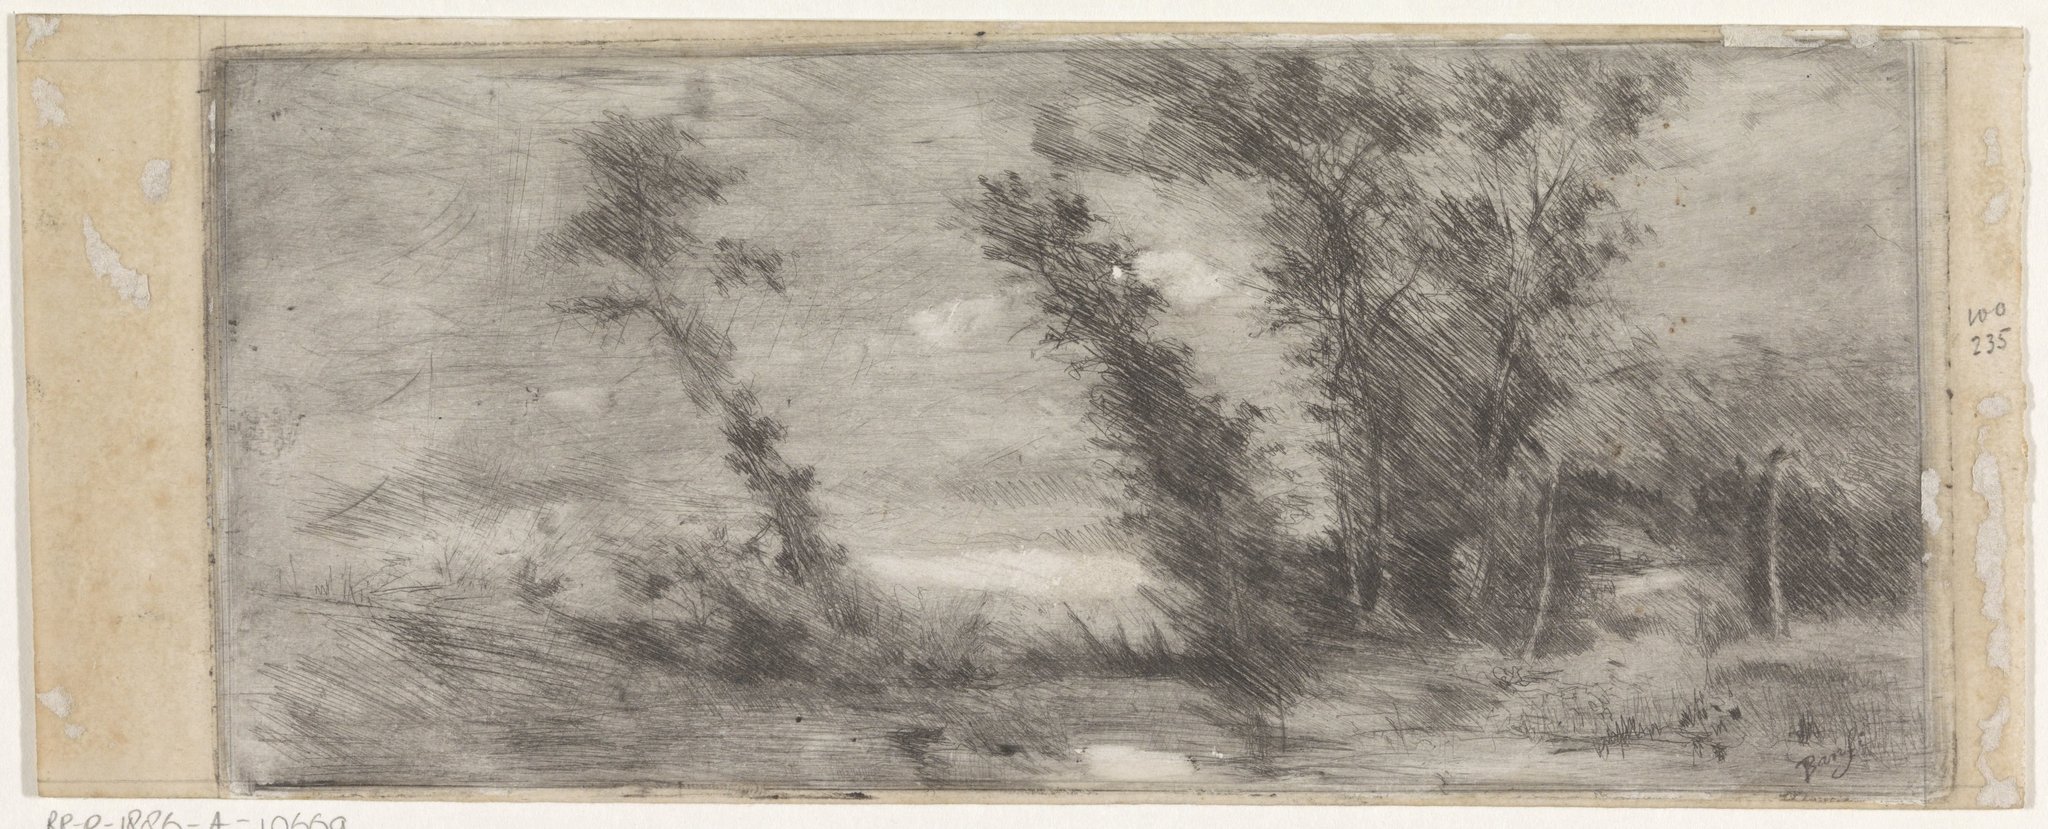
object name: print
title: Landschap met bomen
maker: banfi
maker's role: print maker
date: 1800-1886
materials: paper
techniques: drypoint, intaglio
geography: italy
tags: landscapes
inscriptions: collector's mark: Lugt 2228